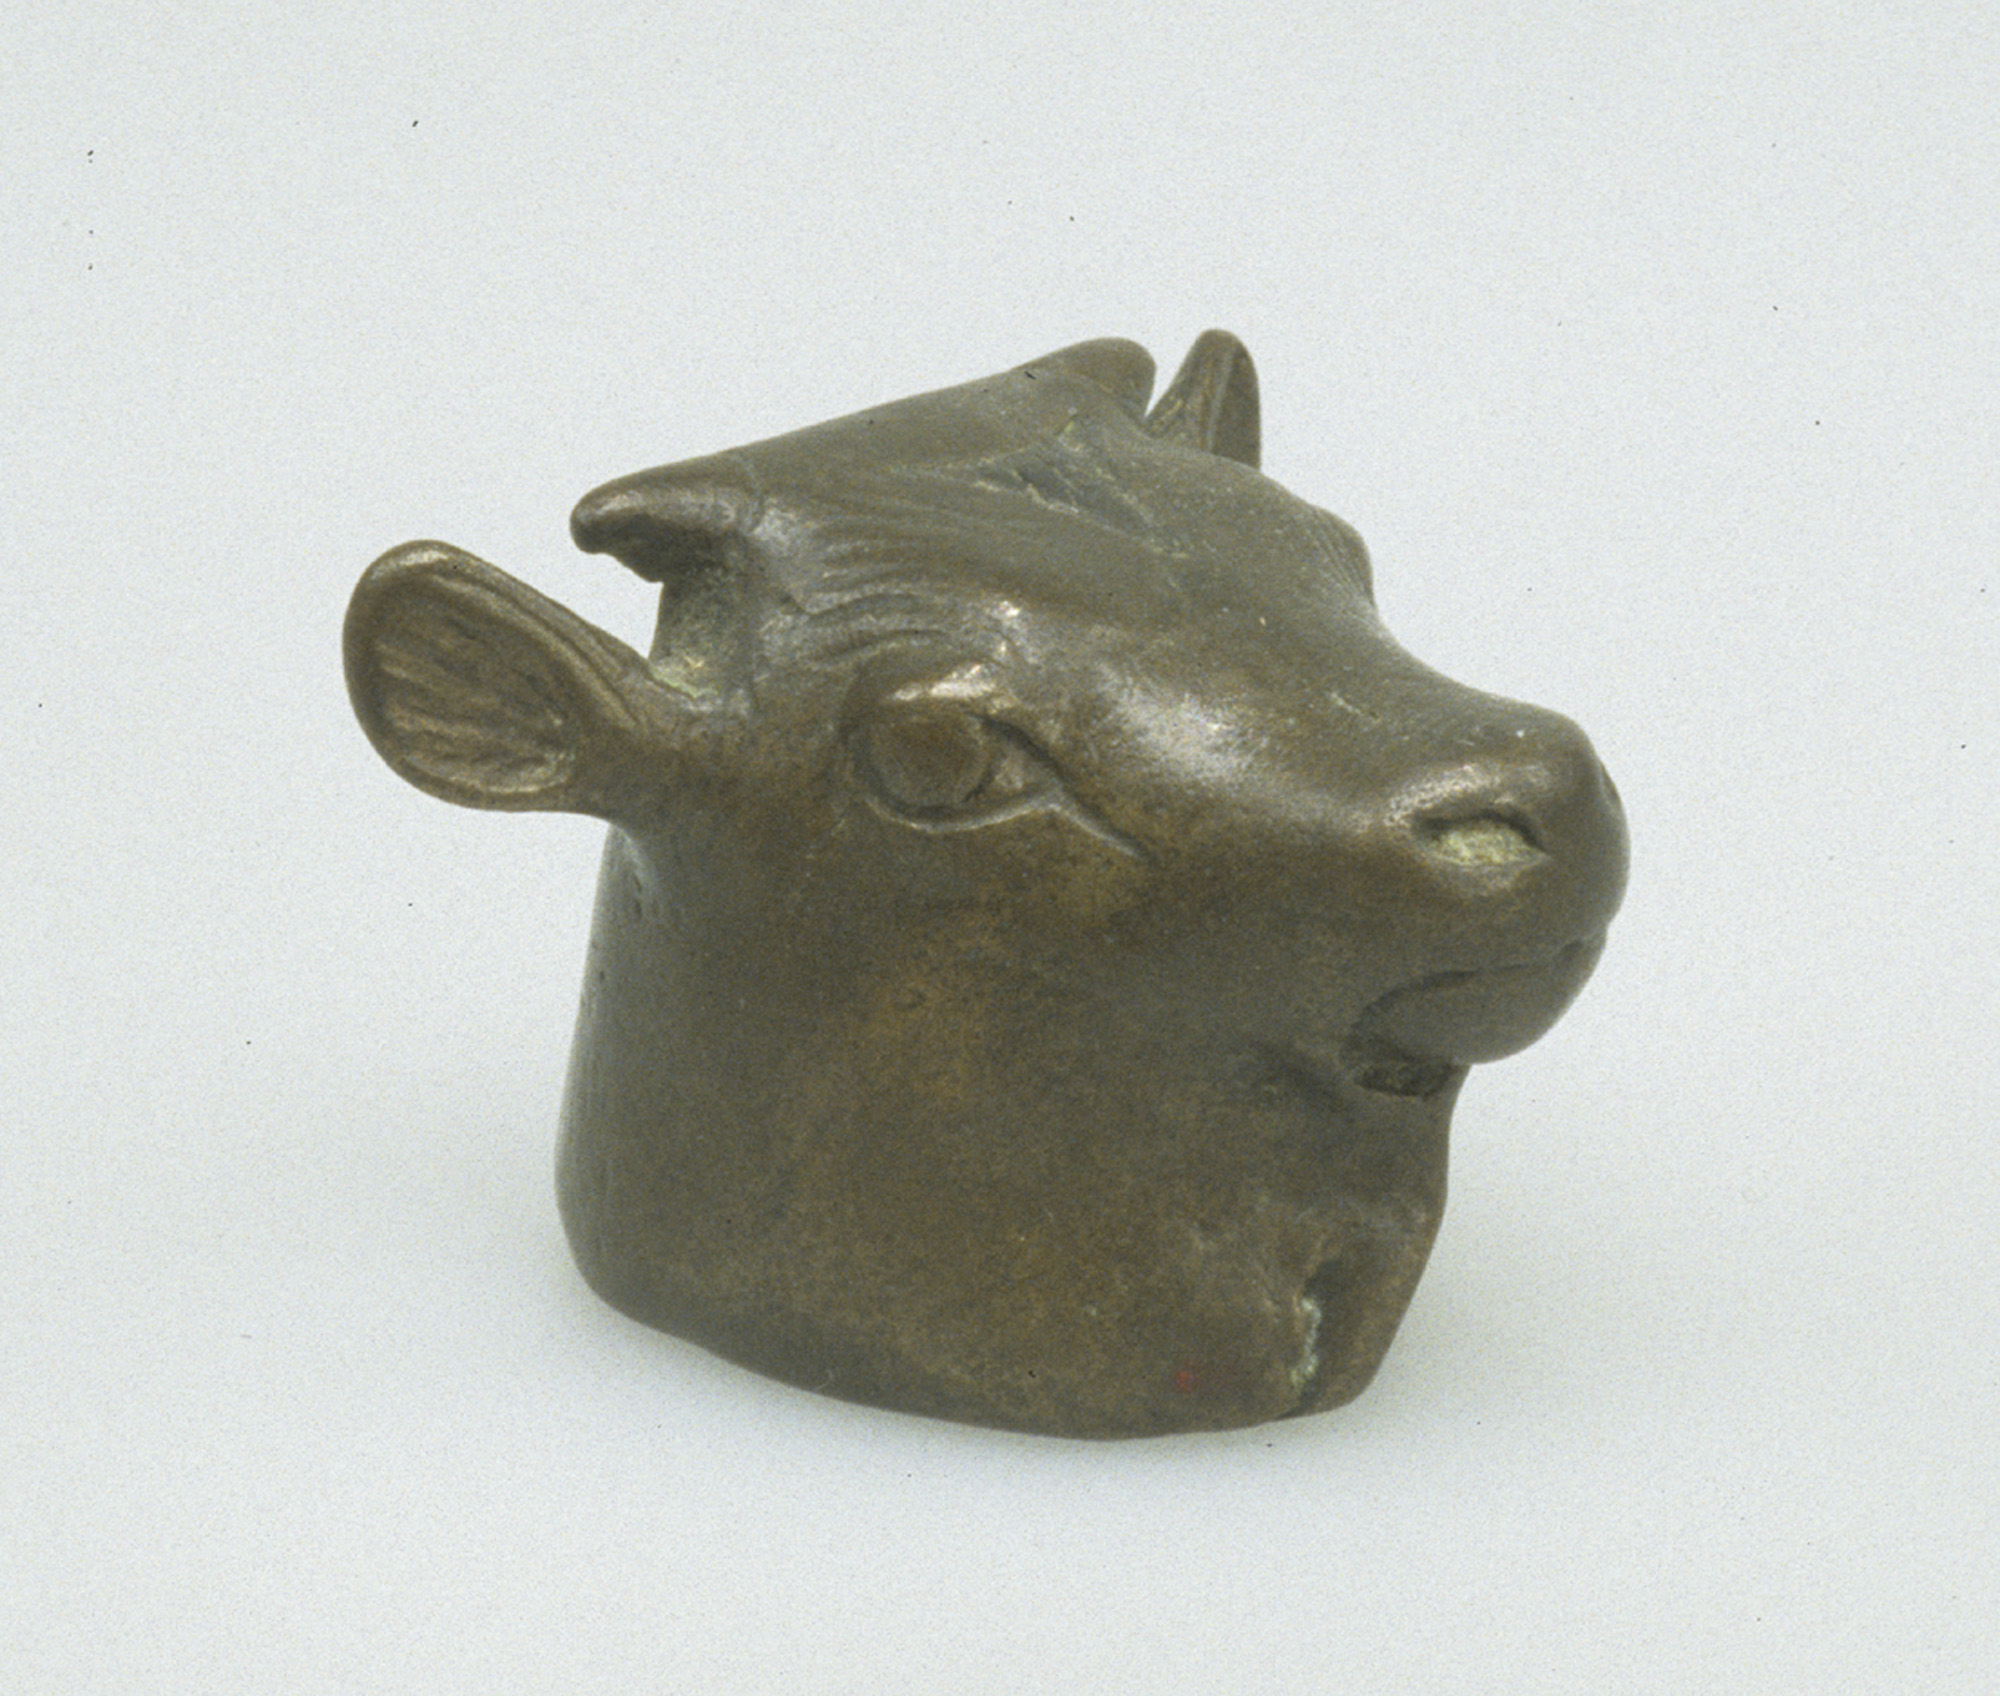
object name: weight, 2 deben, bull's head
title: Bull's-Head Weight of 2 Deben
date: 1550-1391 BCE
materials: bronze, copper alloy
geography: egypt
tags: bulls